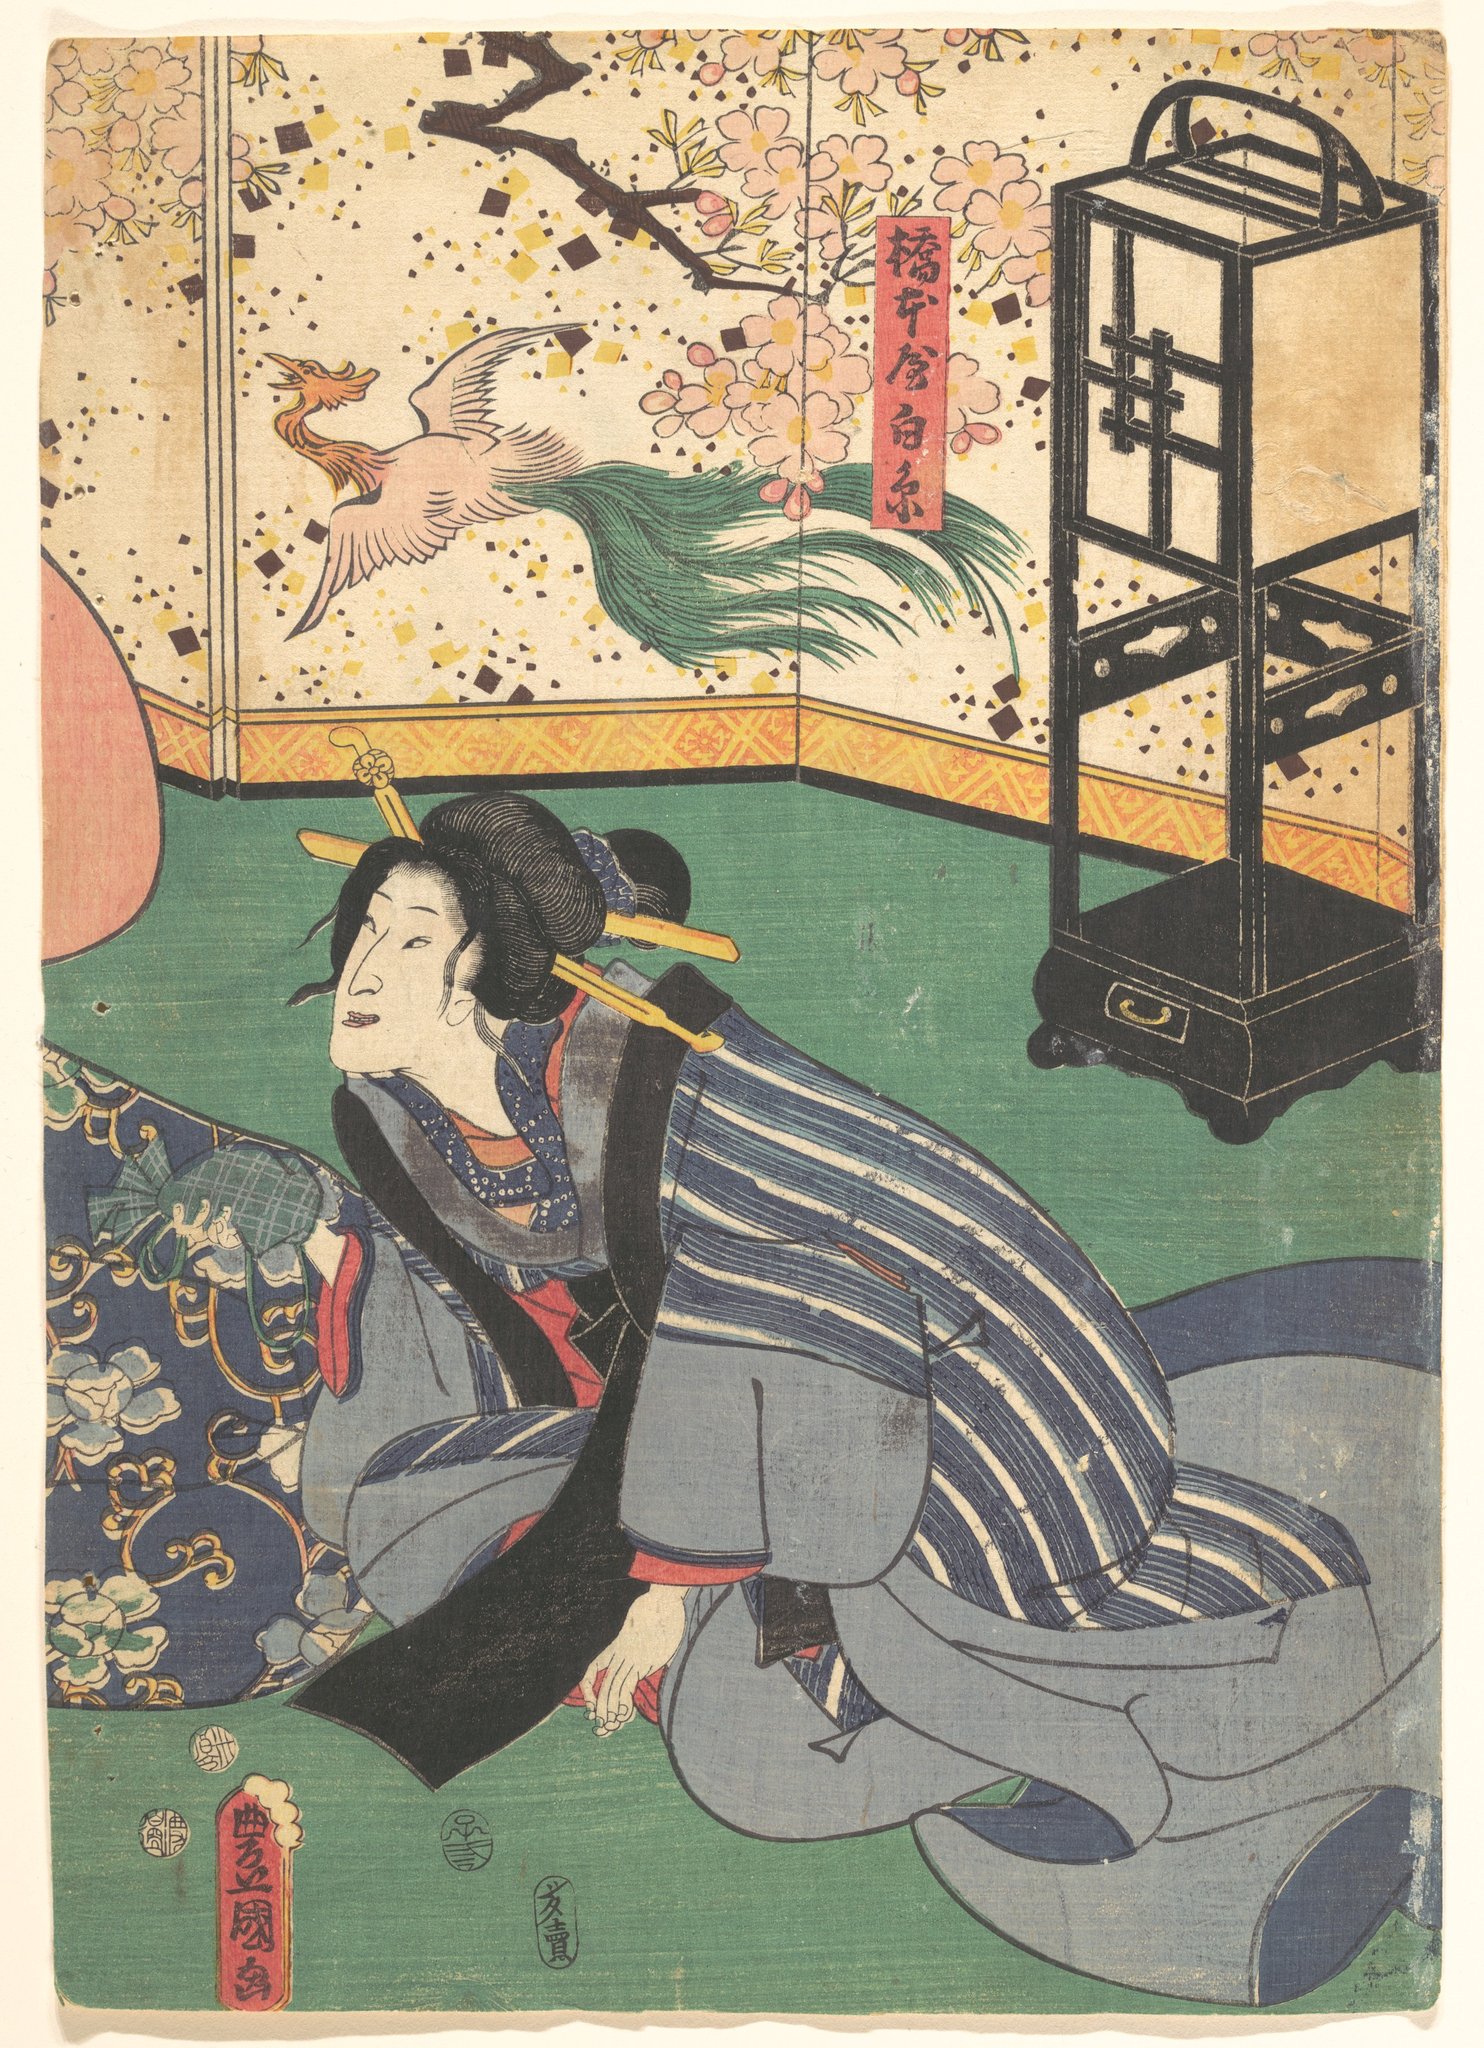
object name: print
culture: japanese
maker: utagawa kunisada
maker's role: artist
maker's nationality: japanese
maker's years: 1786-1864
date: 1801-1900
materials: ink, paper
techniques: woodblock print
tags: birds,women,flowers